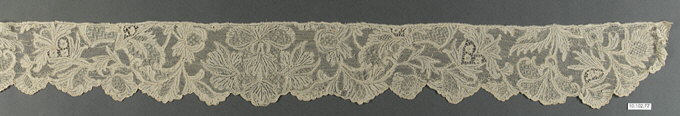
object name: fragment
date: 1701-1733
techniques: lace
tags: flowers,leaves